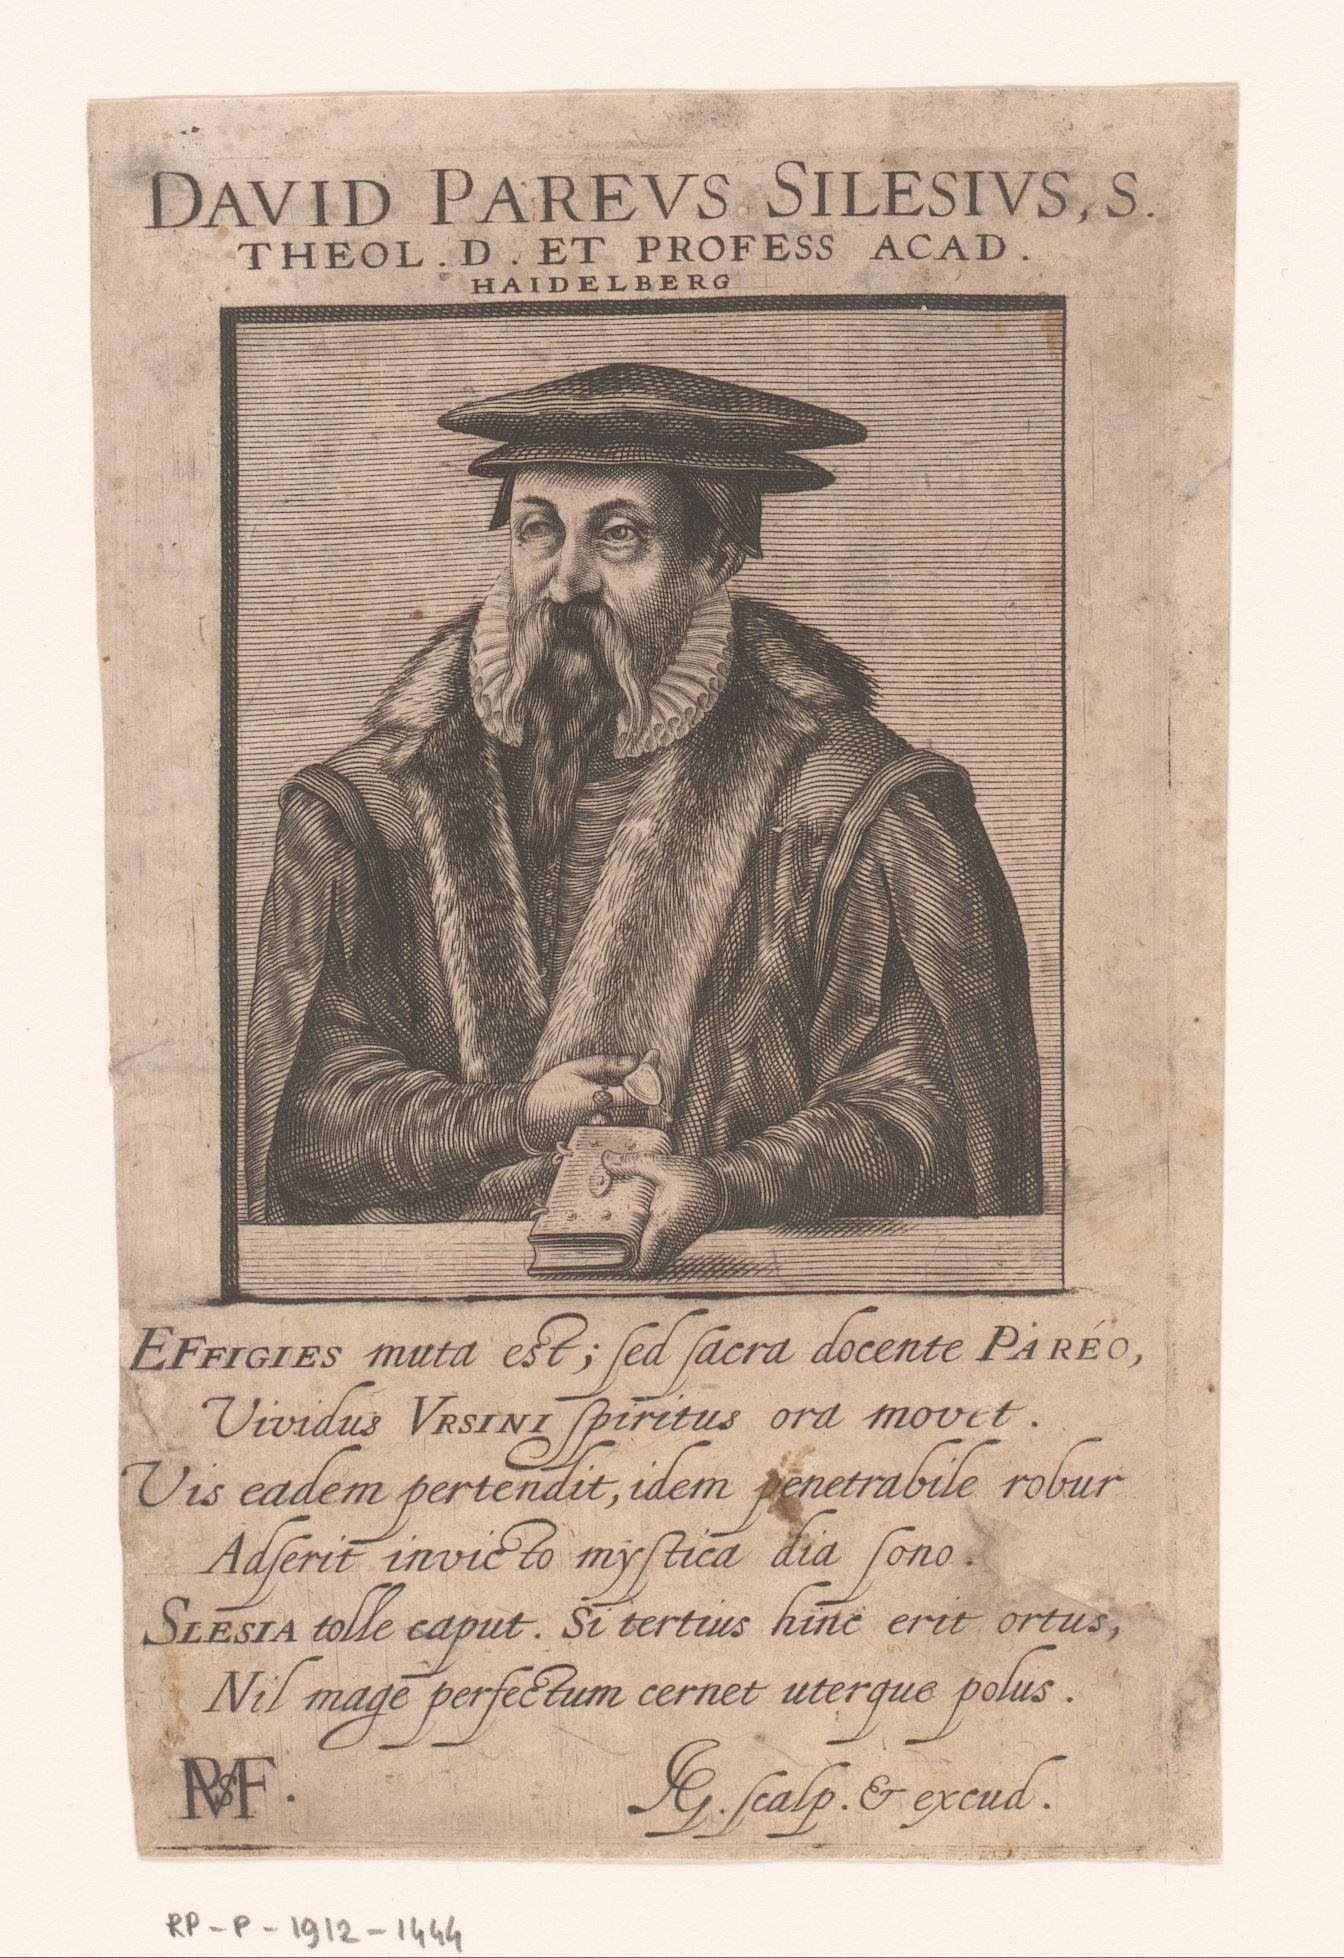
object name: print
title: Portret van David (II) Pareus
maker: jacques granthomme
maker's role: print maker, publisher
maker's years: 1550-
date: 1588-1622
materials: paper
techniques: engraving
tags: theologian, historical persons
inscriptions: collector's mark: Lugt 2228, inscription